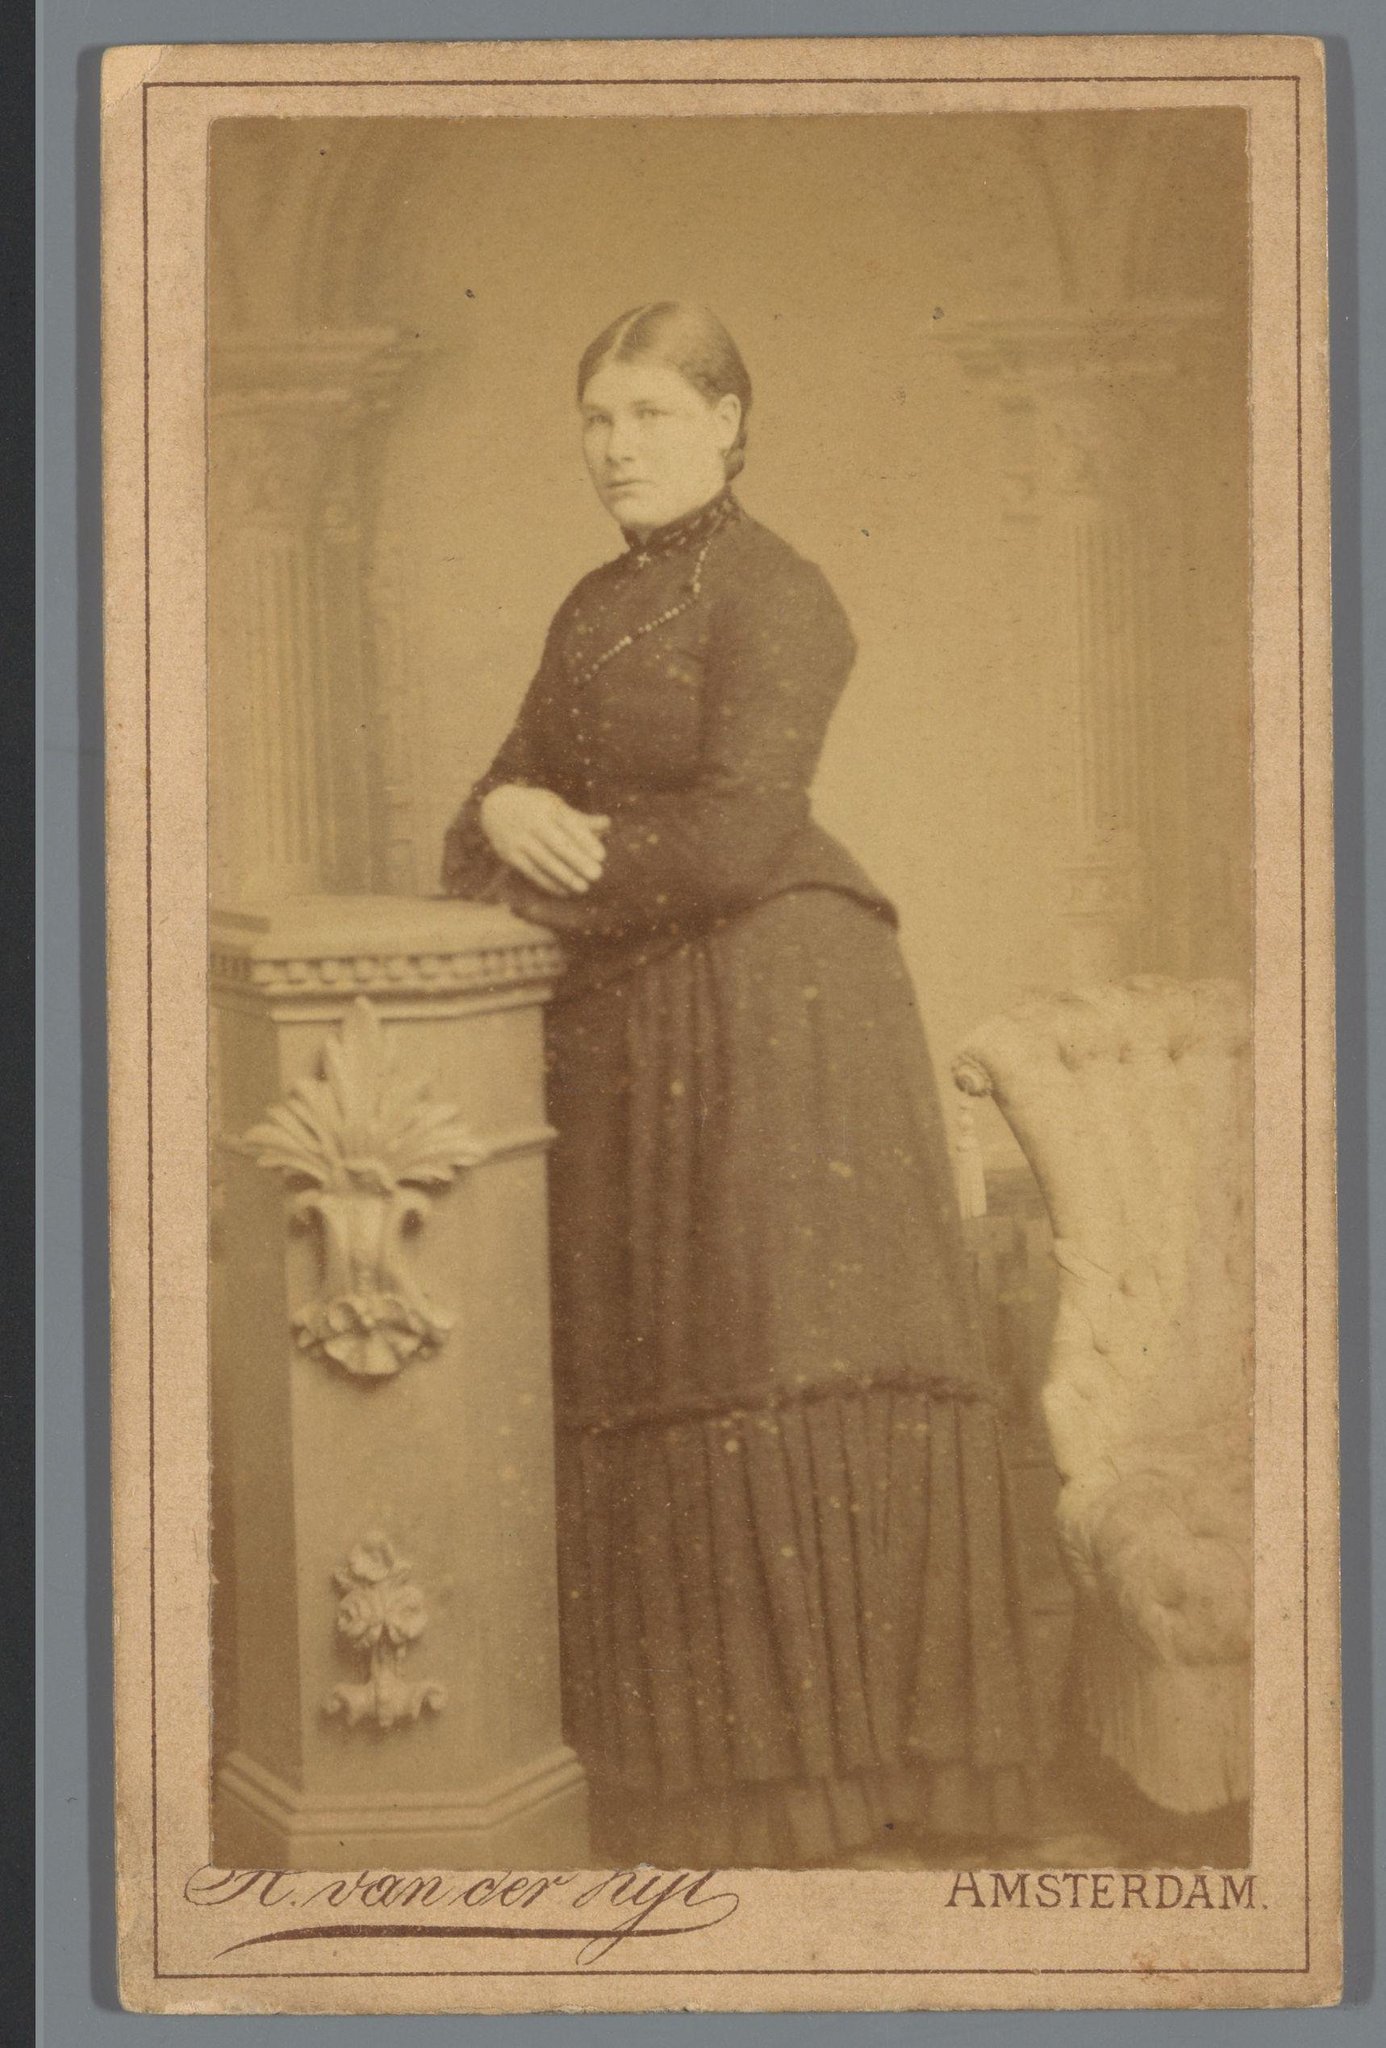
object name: carte de visite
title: Portret van een onbekende vrouw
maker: h. van der zijl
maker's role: fotograaf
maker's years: 1852-1937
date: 1886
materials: cardboard, paper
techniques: albumen print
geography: amsterdam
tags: adult woman, anonymous historical person portrayed, amsterdam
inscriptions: monogram: ‘H v. d. Z’, inscription: ‘H. van der Zijl Amsterdam.’, inscription: ‘Photographie Parisienne/ H. van der Zijl/ 60 Nieuwendijk 60/ over Raamskooi/ Amsterdam’, inscription: ‘H. van der Zijl/ Photographisch Atelier/ Amsterdam/ Haarlemmerstraat 25./ Portretten in alle Afmetingen, Groepen, Architecturen,/ Fabrieken en andere Gebouwen./ Aan bovenstaand adres kan men van deze/ portretten steeds nabestellen.’